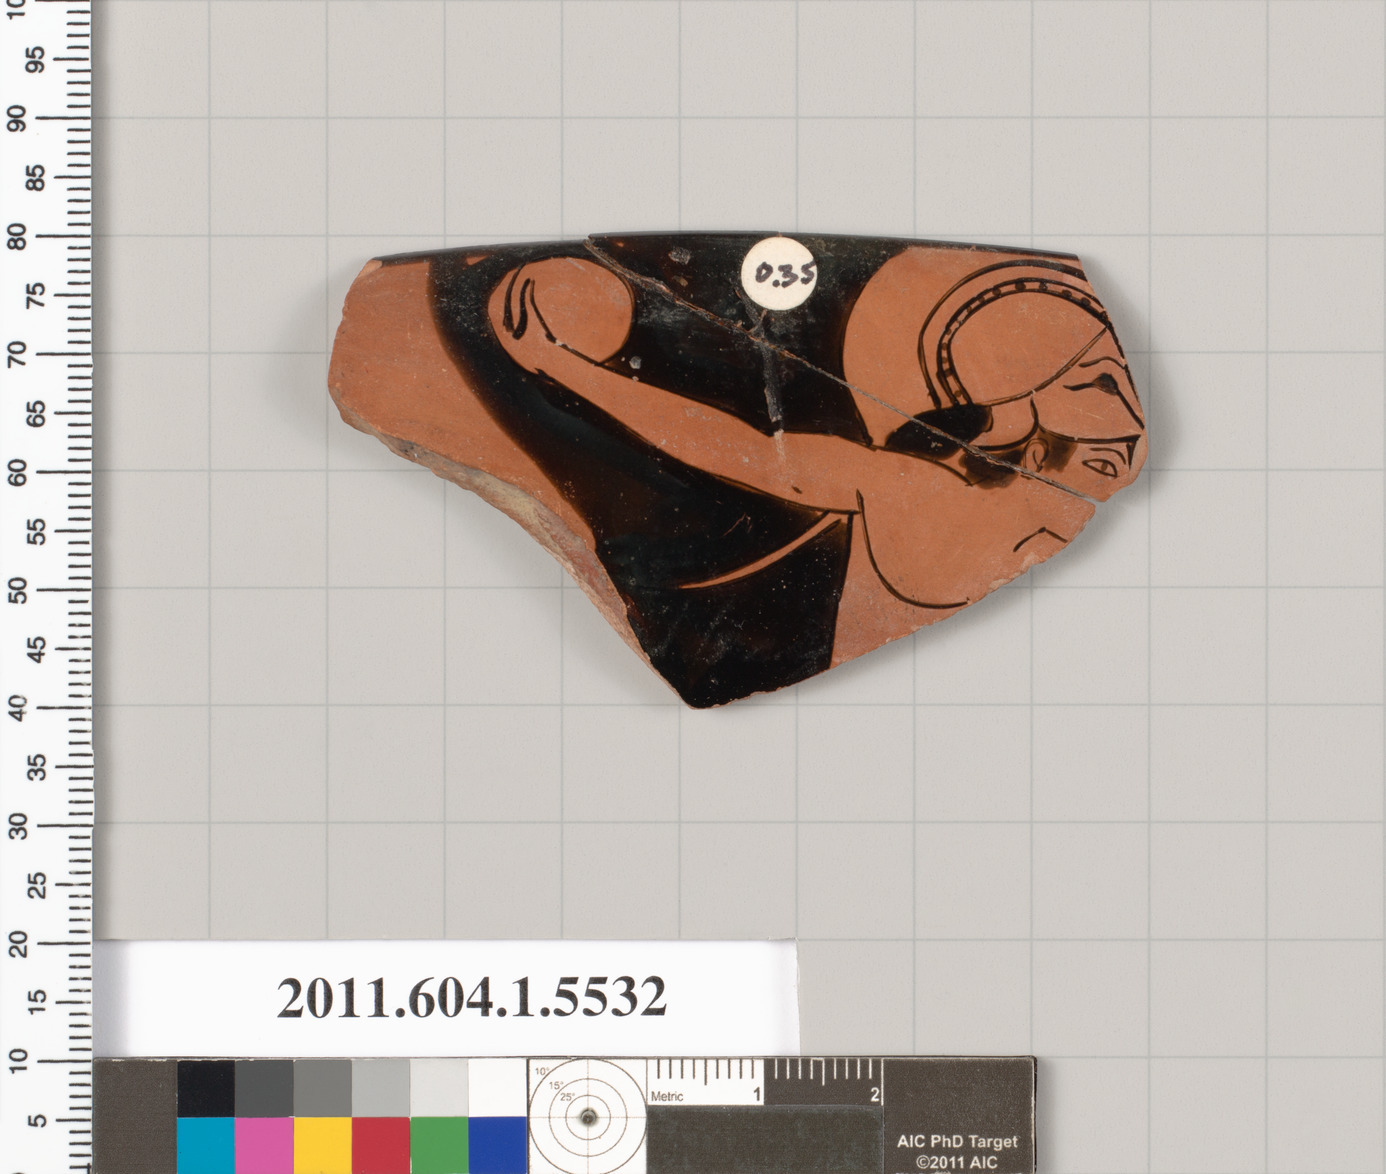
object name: kylix fragment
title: Terracotta rim fragment of a kylix (drinking cup)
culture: greek, attic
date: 500-480 BCE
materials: terracotta